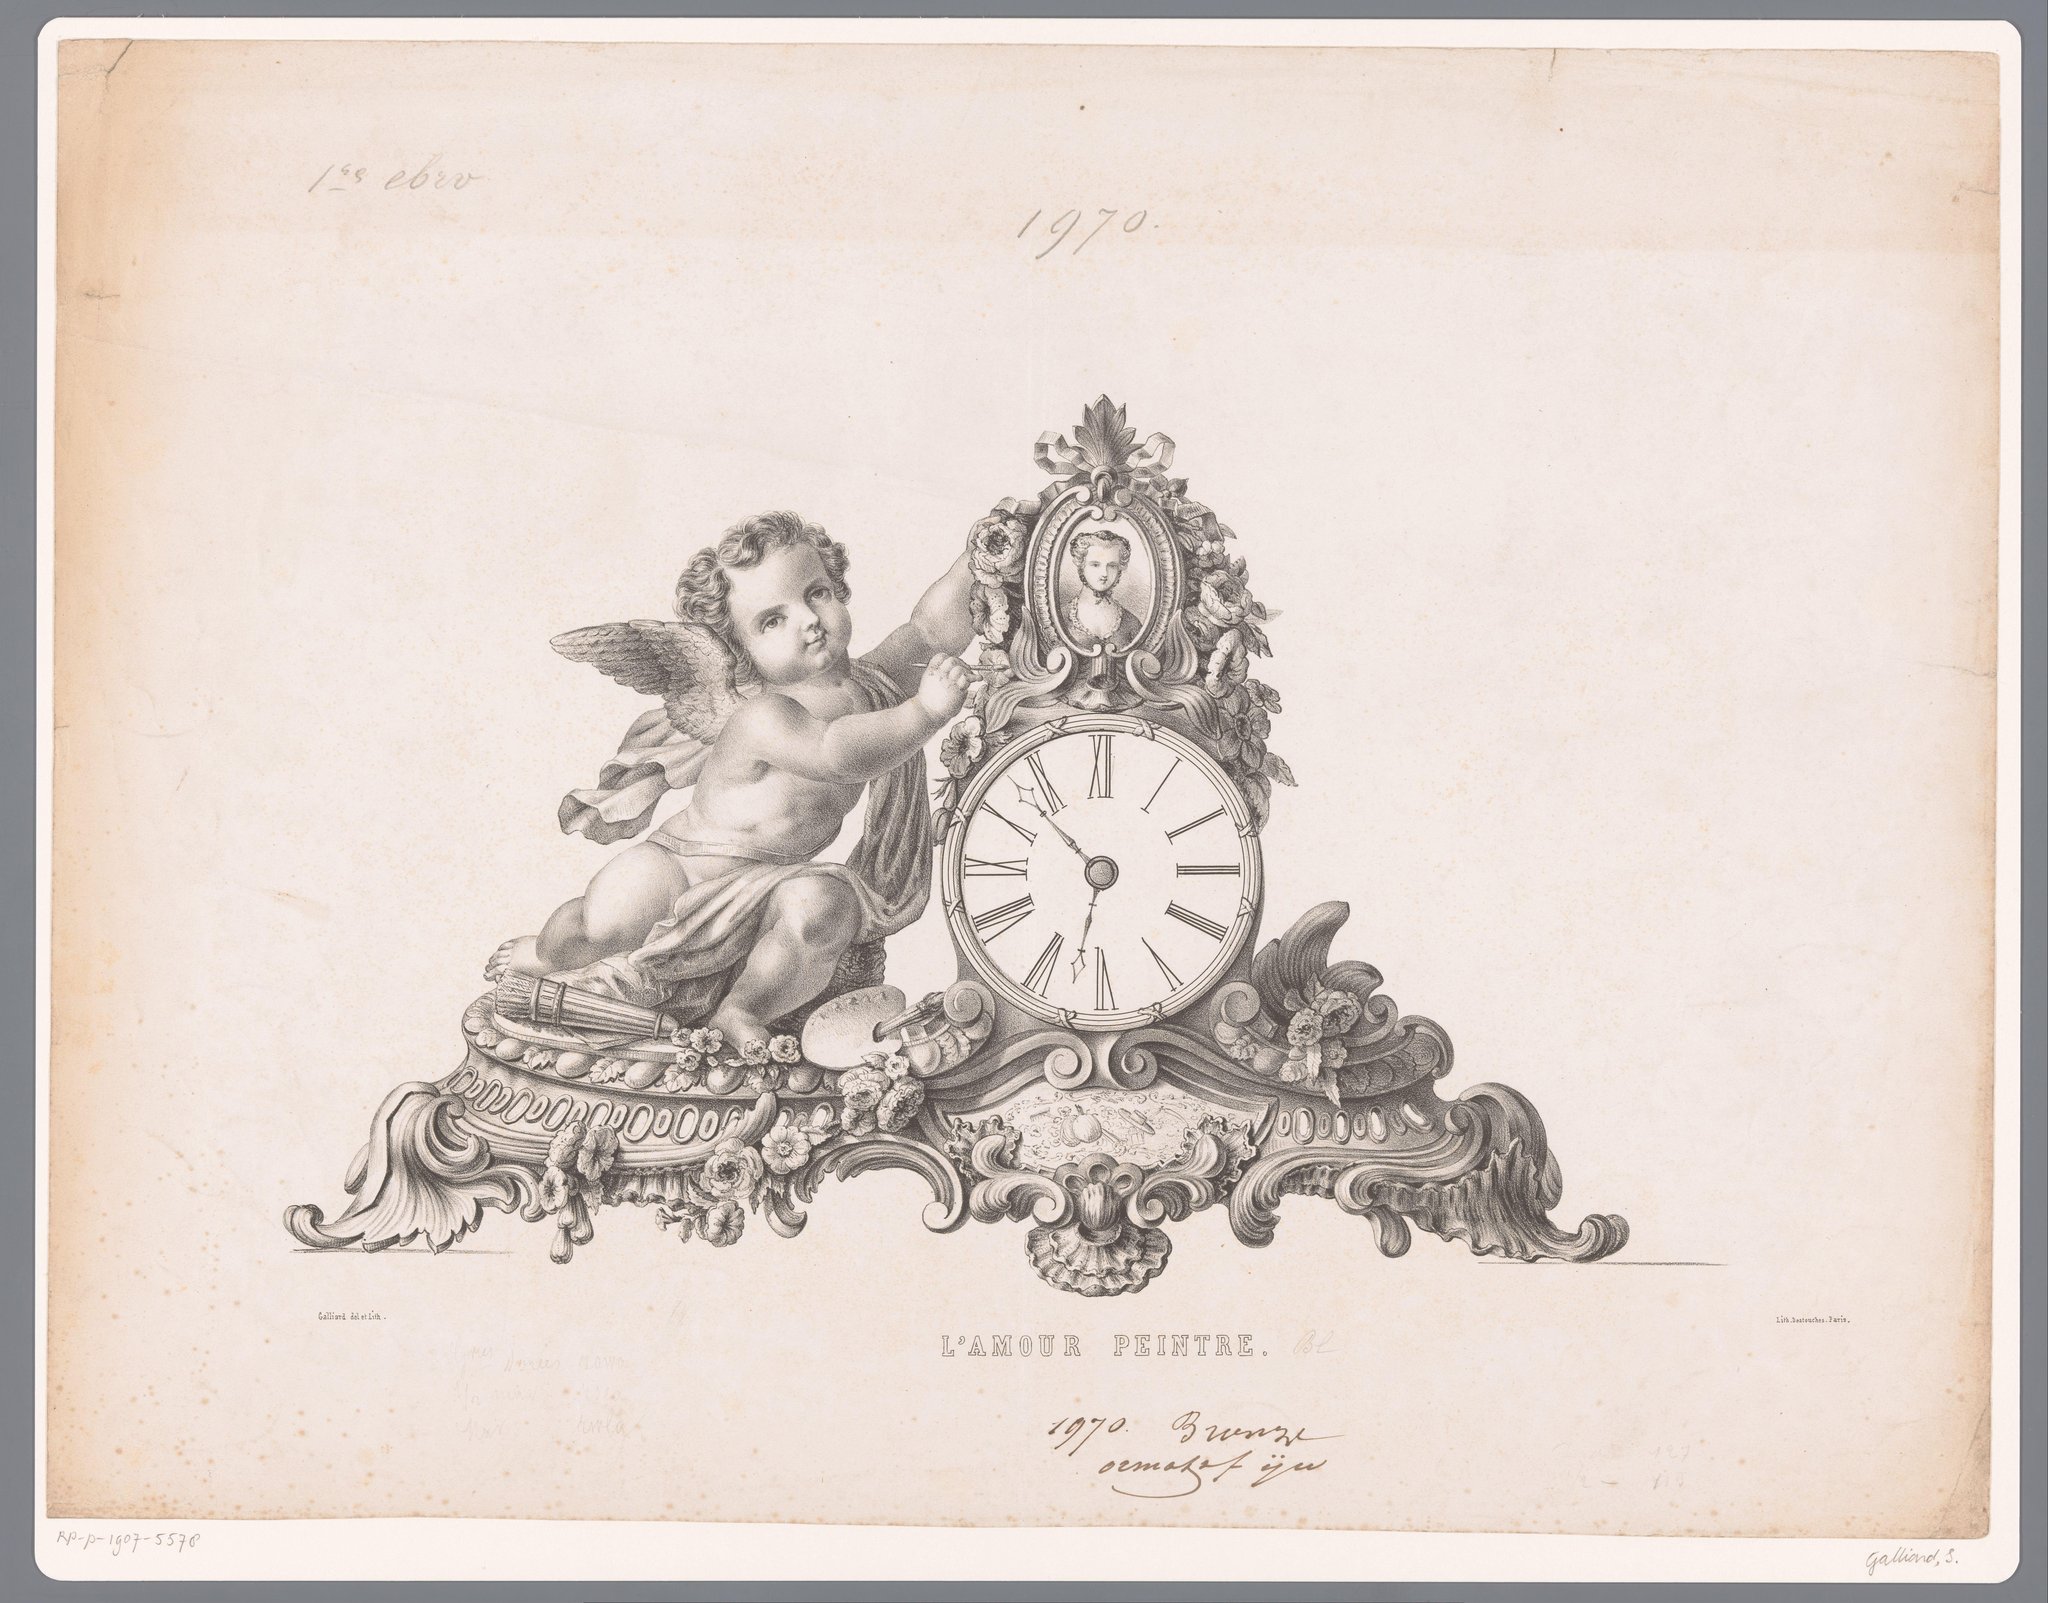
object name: print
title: Klok met putto die een damesportret schildert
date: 1853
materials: paper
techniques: lithograph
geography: paris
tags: ornament ~ medallion, cupids together with attributes of the arts, sciences, etc., clock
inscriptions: collector's mark: Lugt 2228a